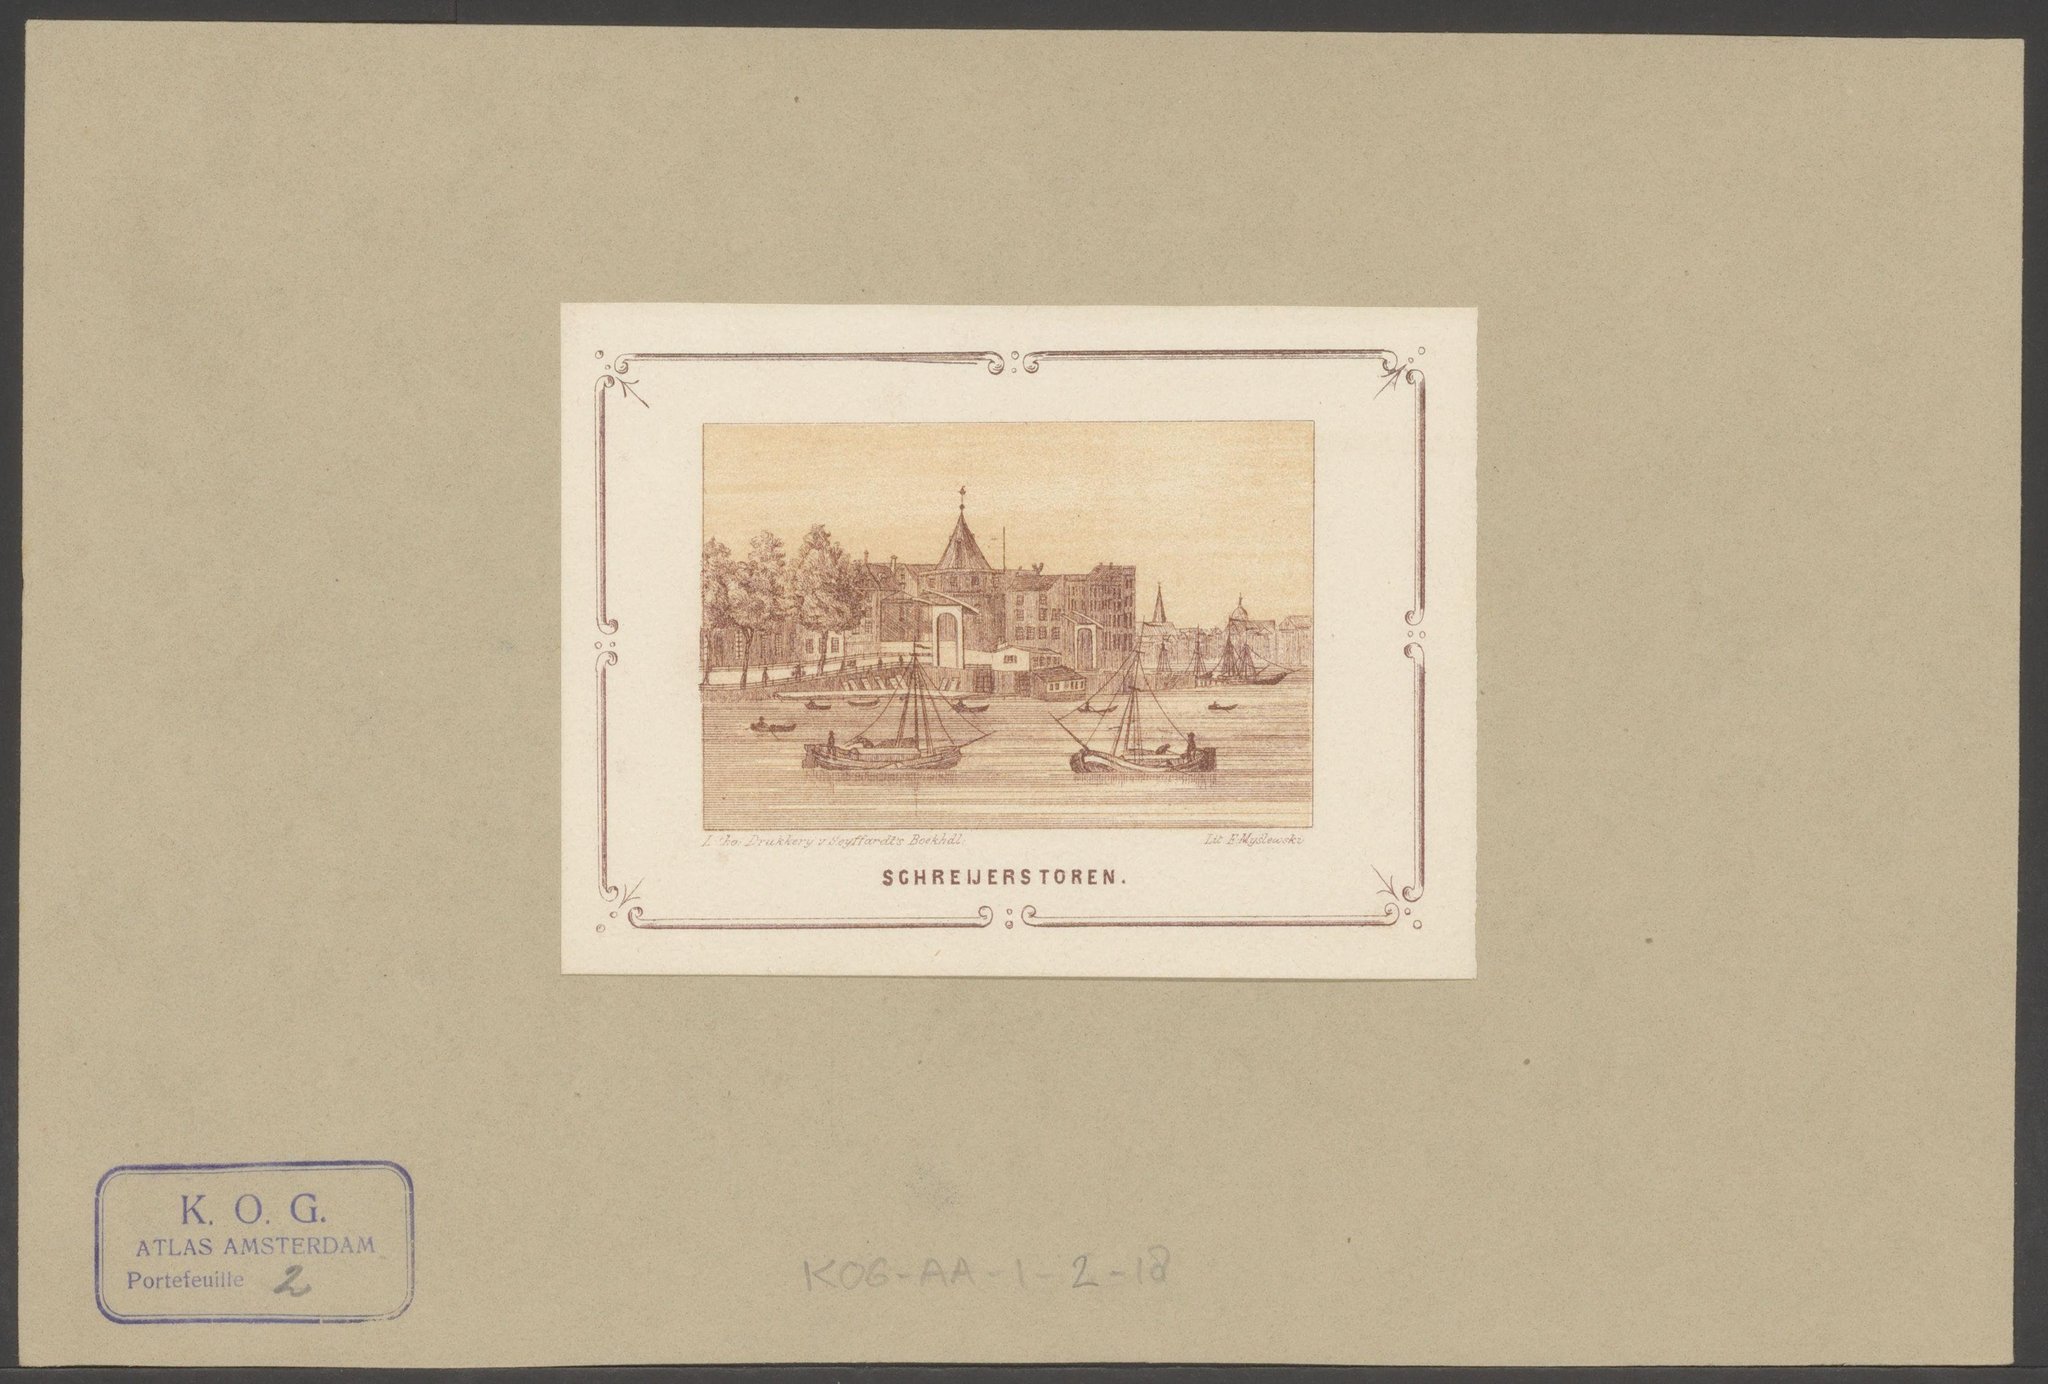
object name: print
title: Schreijerstoren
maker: Anonymous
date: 1849-1926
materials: paper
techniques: tone lithography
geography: amsterdam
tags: tower, clock tower ~ monumental adornment, city-view in general; 'veduta', canal, bridge in city across river, canal, etc., boat propelled by man or animal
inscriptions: collector's mark: ‘2’ Lugt 1641b, signature: ‘E. Mysleuski’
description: Onderwerpsrubriek binnen de Atlas Amsterdam: Gezichten van het IJ op het Oostelijk gedeelte der stad, Nieuwebrug tot Zeeburg.